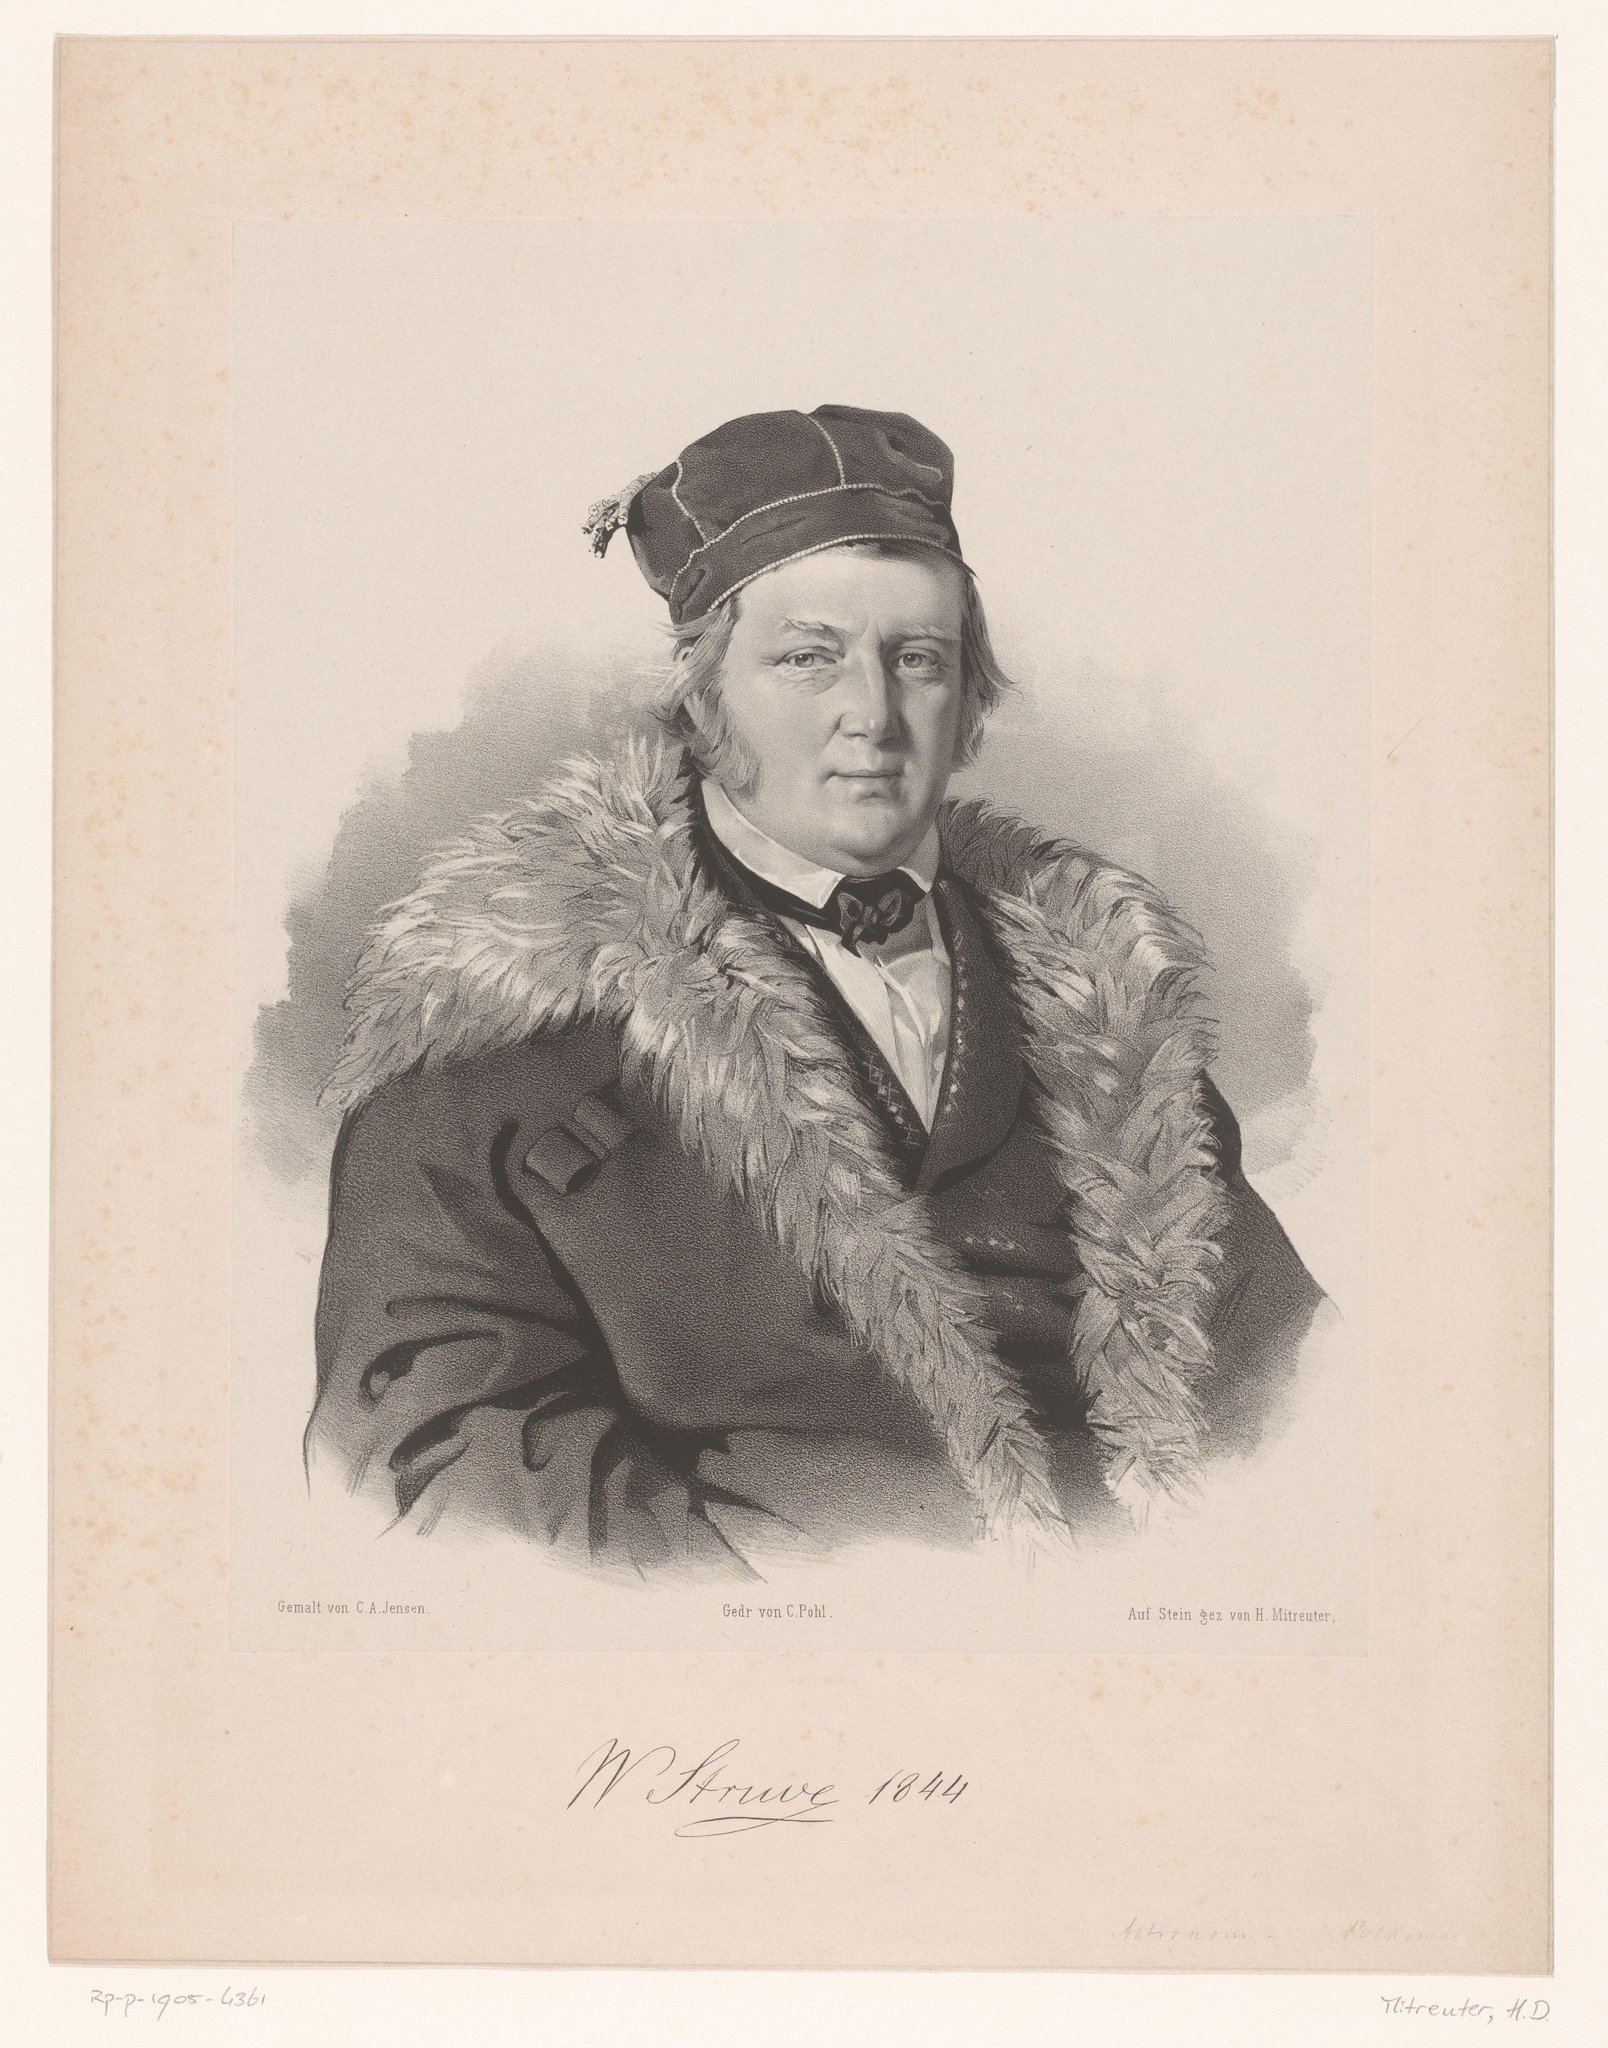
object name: print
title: Portret van Friedrich Georg Wilhelm Struve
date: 1844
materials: paper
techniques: lithograph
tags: historical persons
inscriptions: signature: ‘Gemalt von C.A. Jensen’, collector's mark: Lugt 2228, date: ‘W Struve 1844’, signature: ‘Auf Stein gez von H. Mitreuter’, signature: ‘Gedr von C. Pohl.’